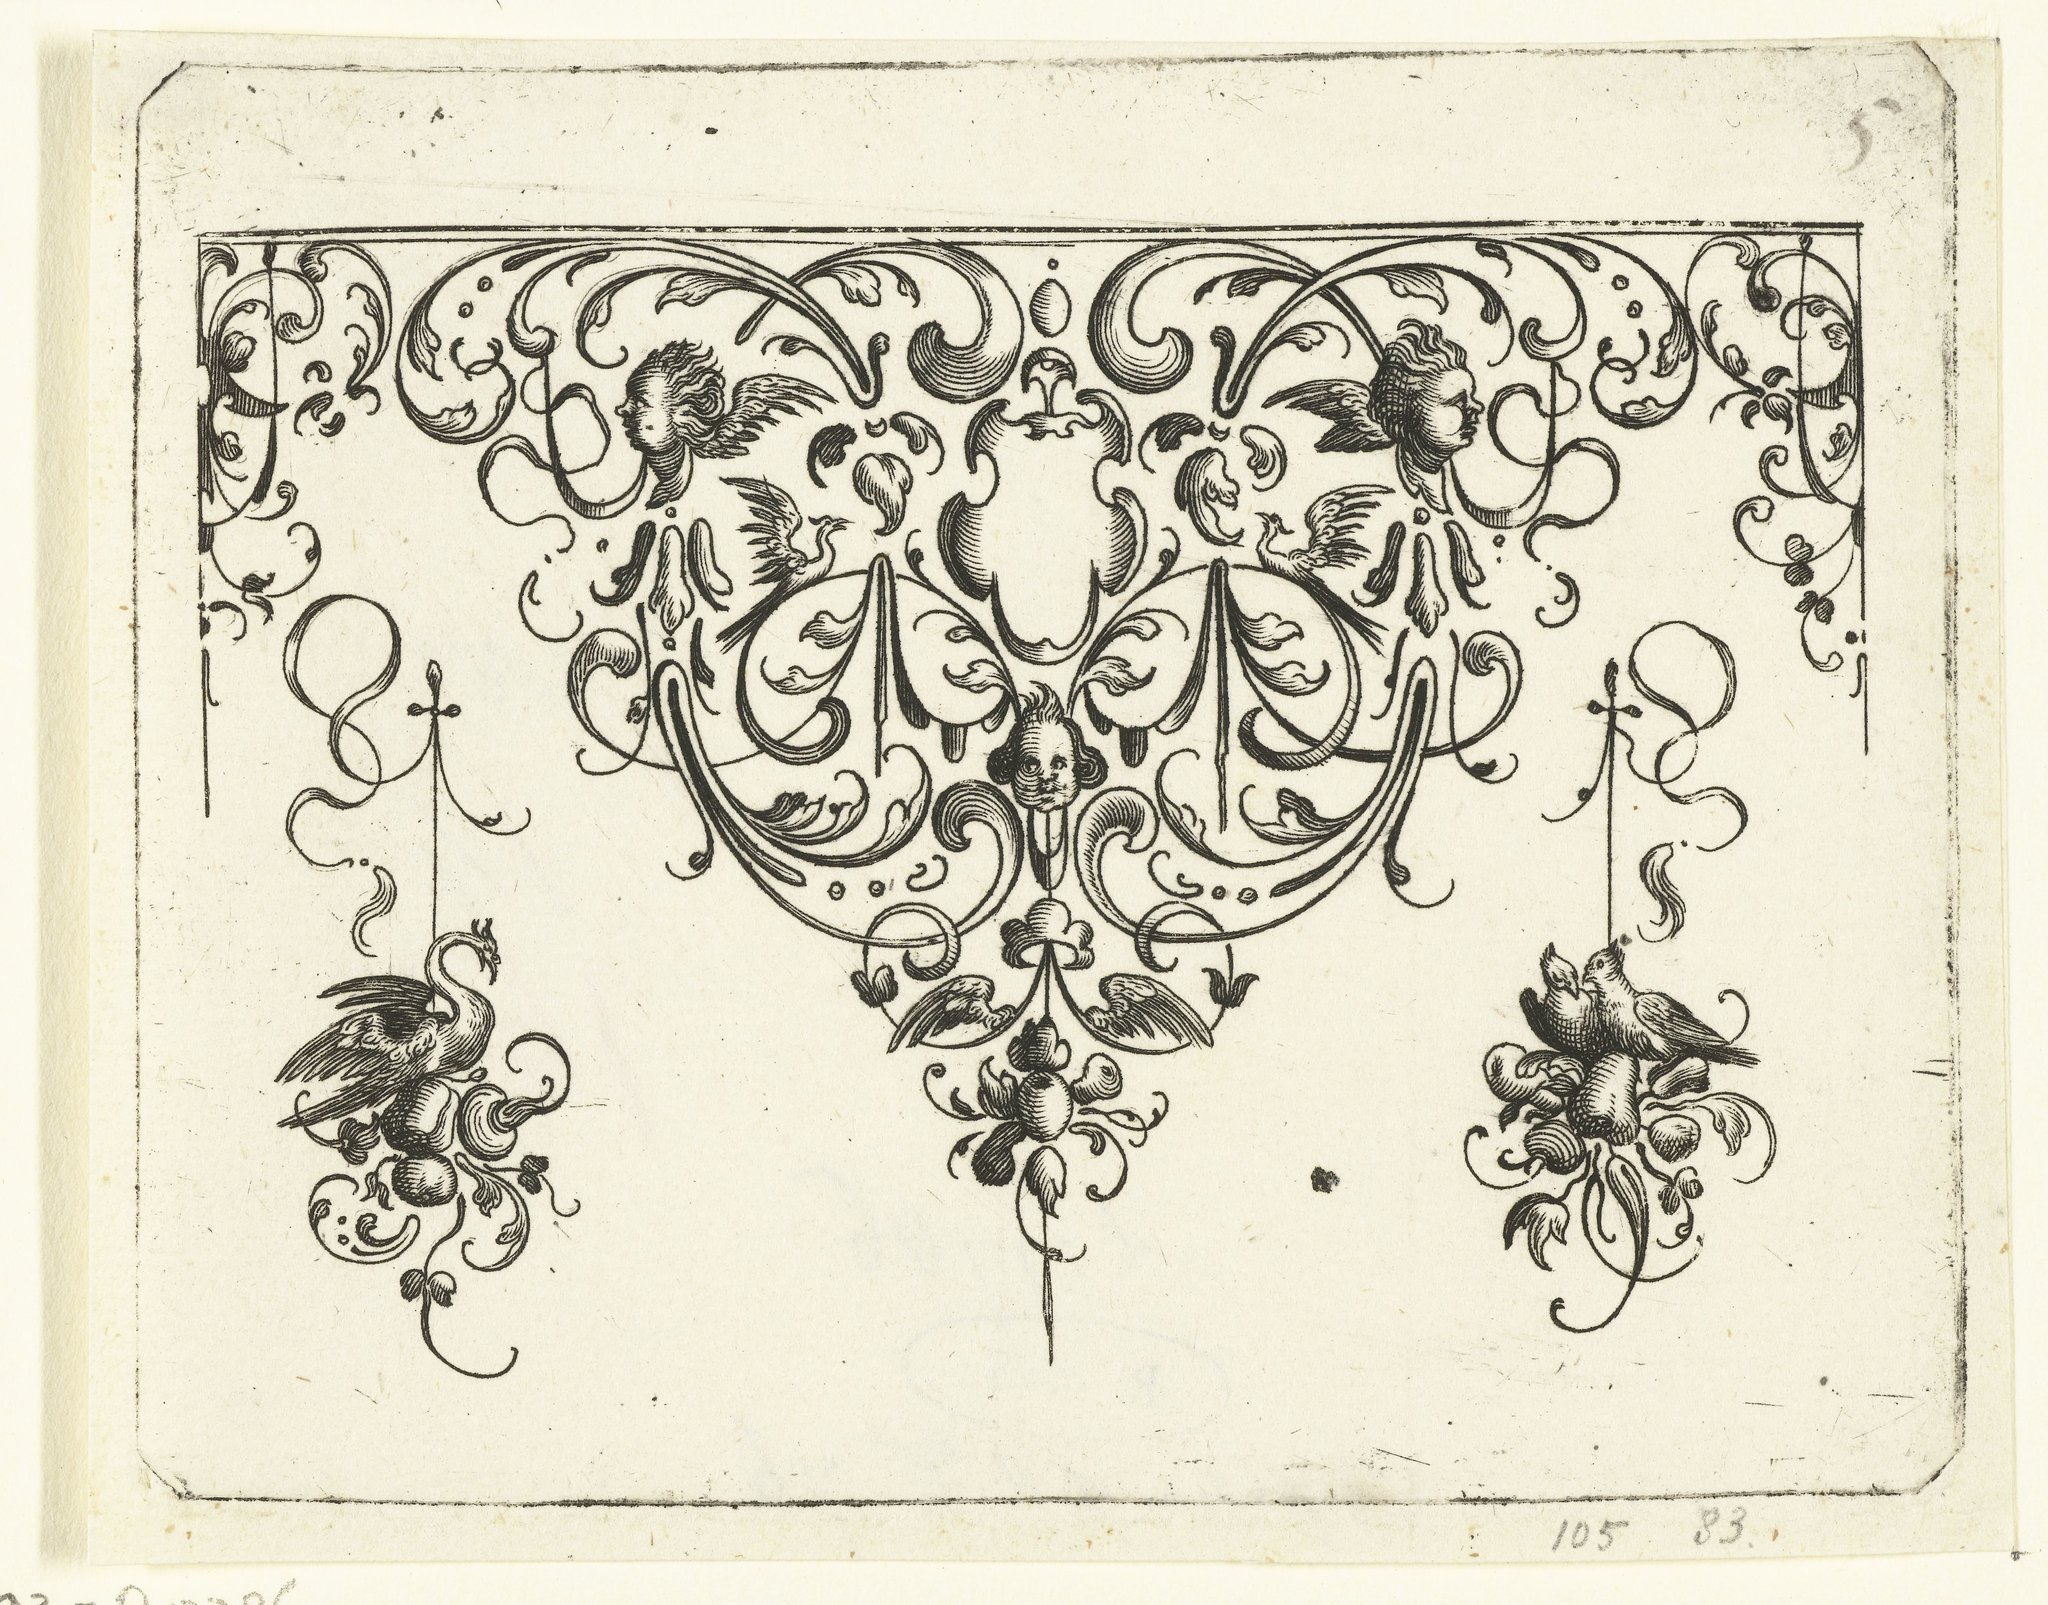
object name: print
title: Spits met een lege cartouche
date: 1611-1635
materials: paper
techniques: engraving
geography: nuremberg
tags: foliage ~ ornament, ornament ~ cartouche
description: Kopie van serie met dezelfde titel, uitgegeven door Michiel le Blon. Blad 5 uit serie van 14 bladen met voorbeelden voor gegraveerde decoratieranden van bekers in de vorm van driehoeken bestaande uit ranken, Schweifwerk, guirlandes met putti, dieren, vogels en maskers.